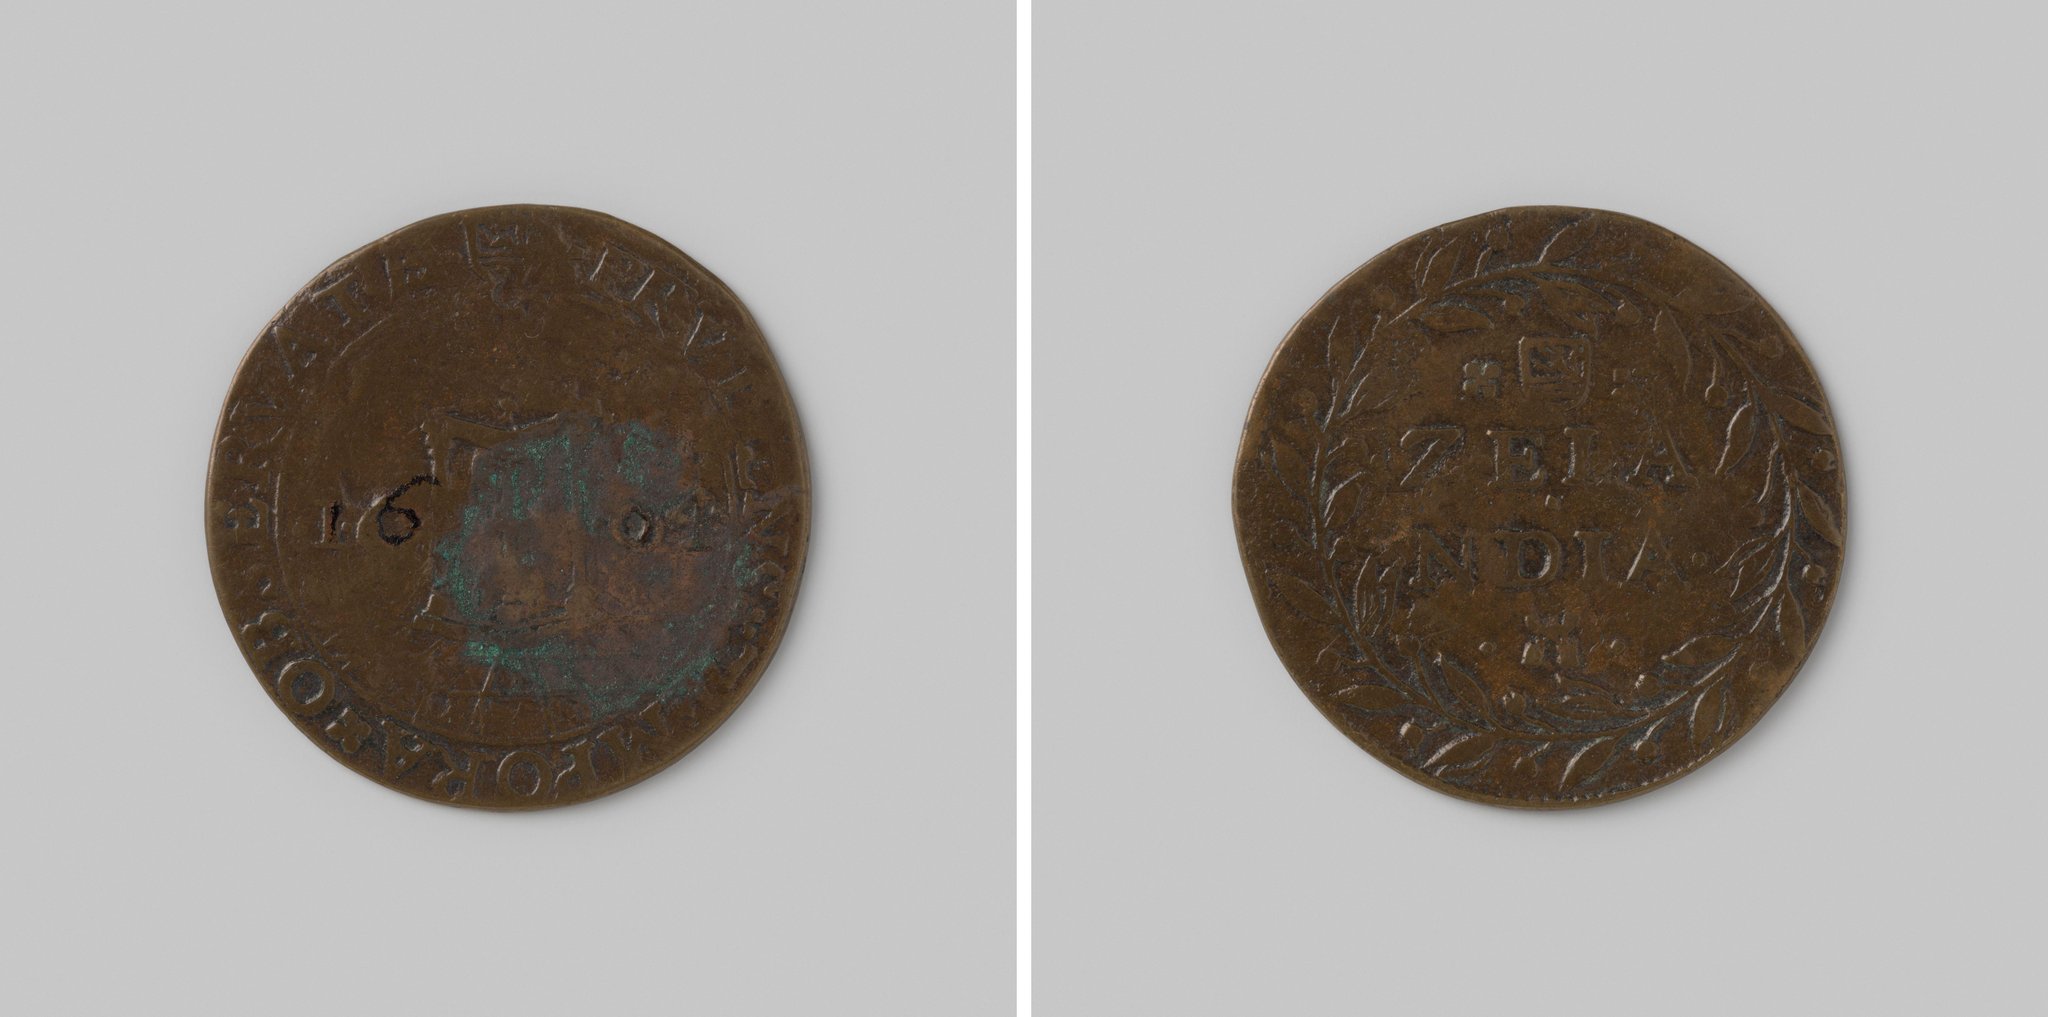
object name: jeton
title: Rekenpenning uit Middelburg op de gerustheid in Zeeland 1604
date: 1604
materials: copper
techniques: striking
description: Koperen penning, op de voorzijde een zandloper met het jaartal 1604 ,met omschrift, op de keerzijde twee regels tekst binnen een lauwerkrans.